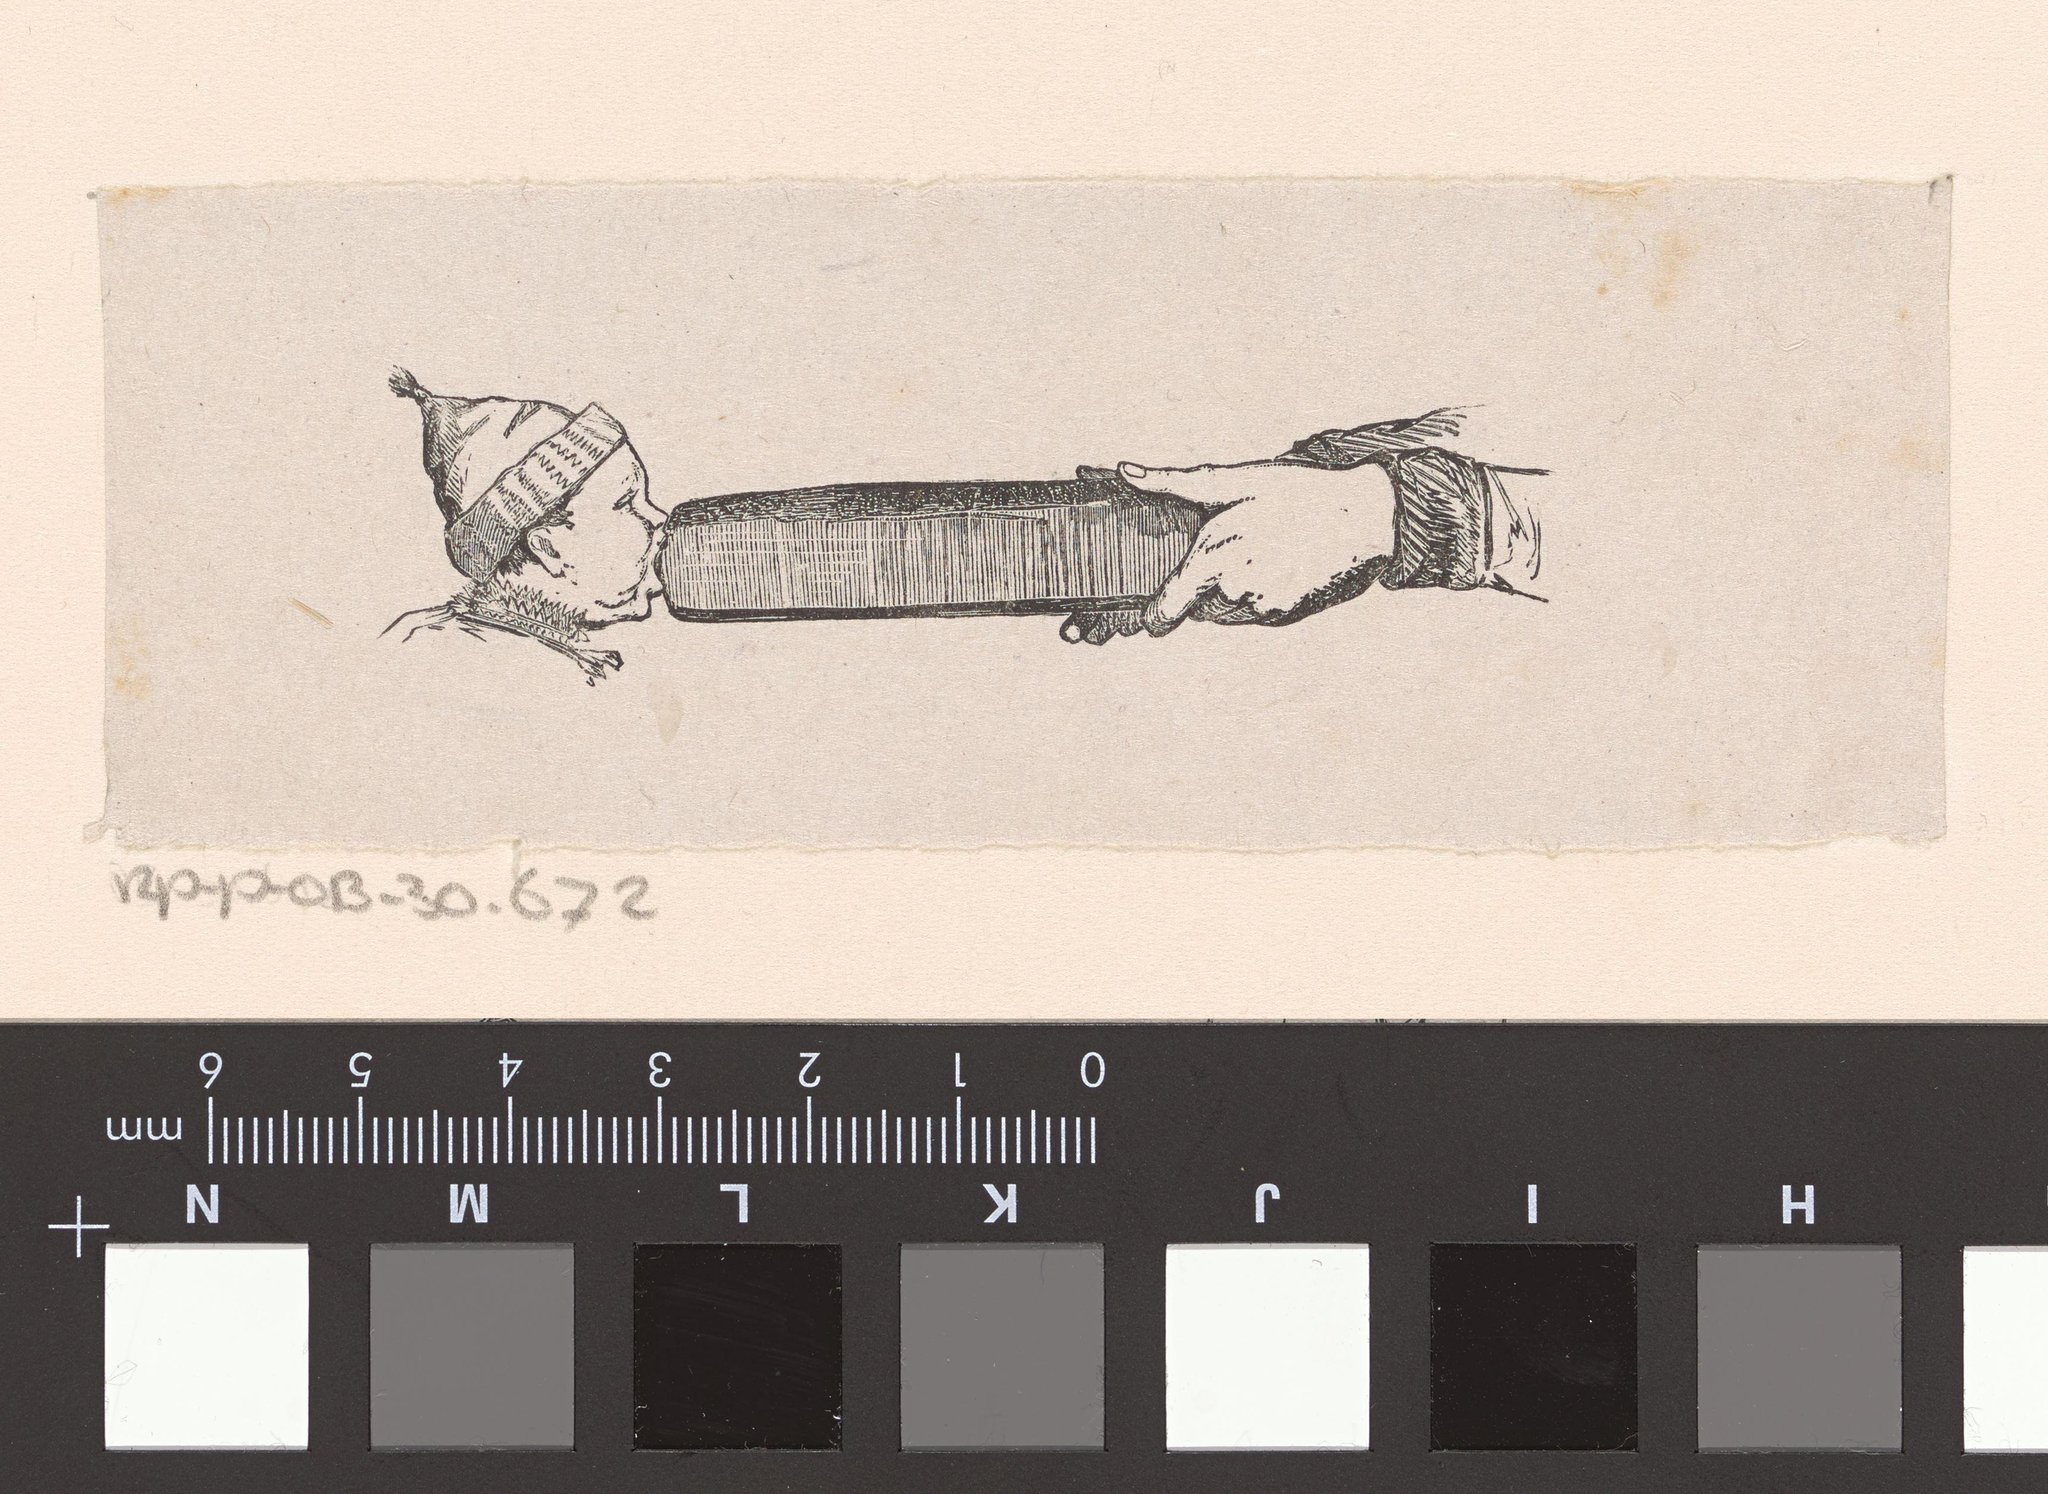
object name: print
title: Jongen met een muts bijtend in een object dat hem wordt voorgehouden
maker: isaac weissenbruch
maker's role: print maker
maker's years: 1826-1912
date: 1836-1912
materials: paper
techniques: engraving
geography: netherlands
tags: biting, child, head-gear: cap